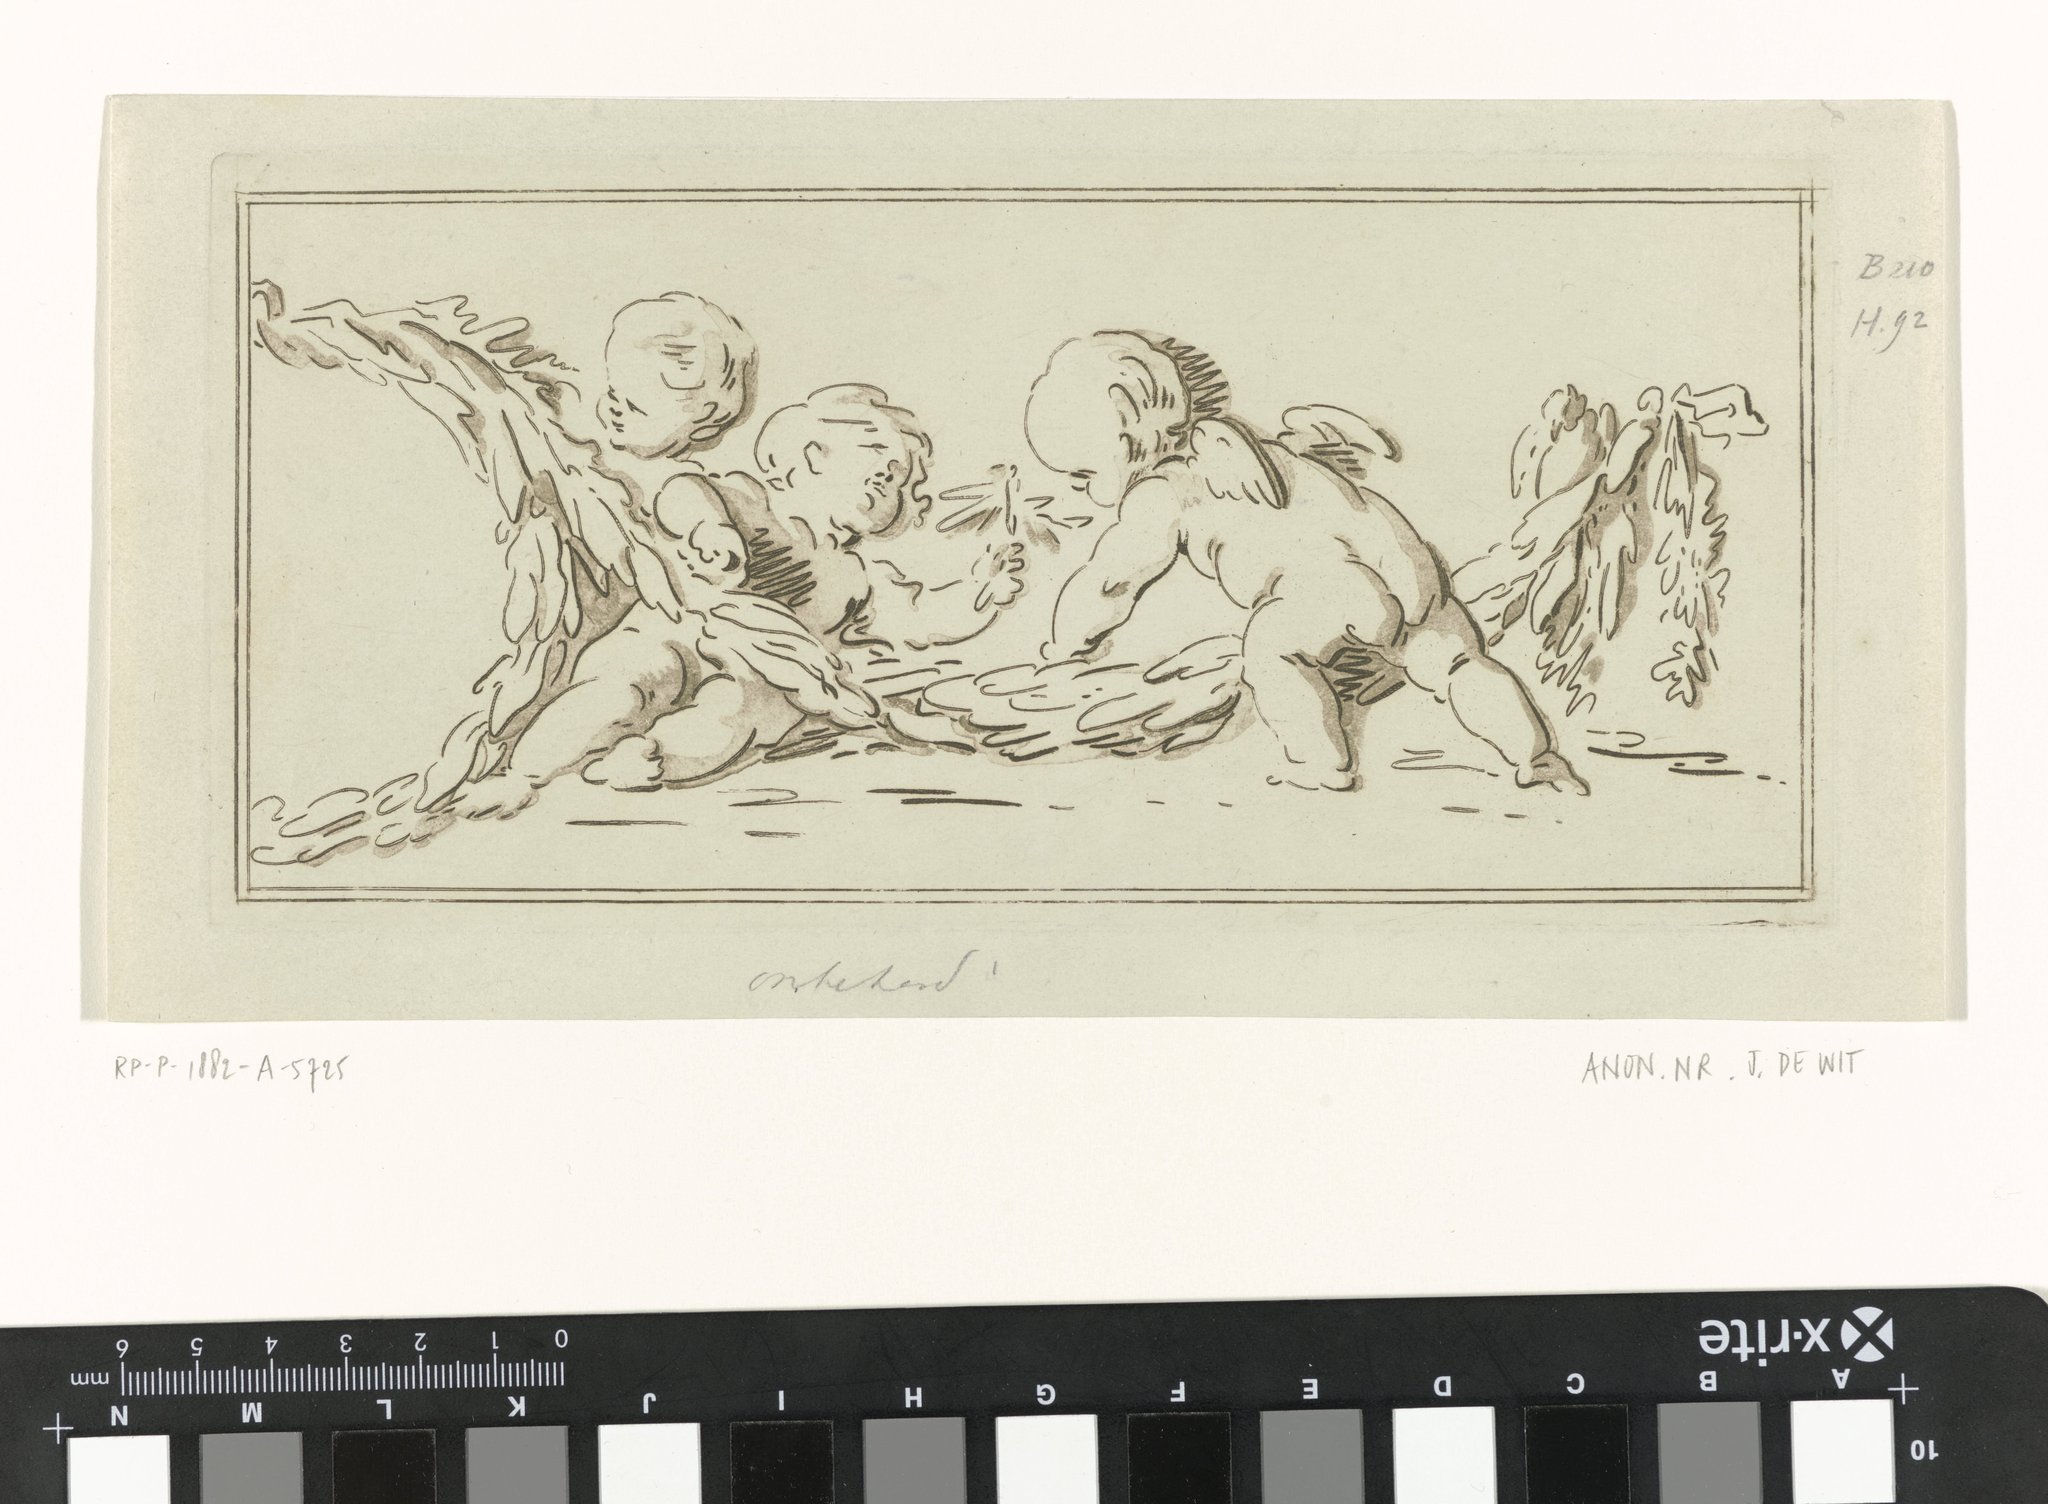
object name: print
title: Drie putti met een guirlande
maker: Anonymous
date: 1705-1804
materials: paper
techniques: aquatint, etching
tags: ornament ~ festoon, garland, cupids: 'amores', 'amoretti', 'putti'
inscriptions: collector's mark: Lugt 2228